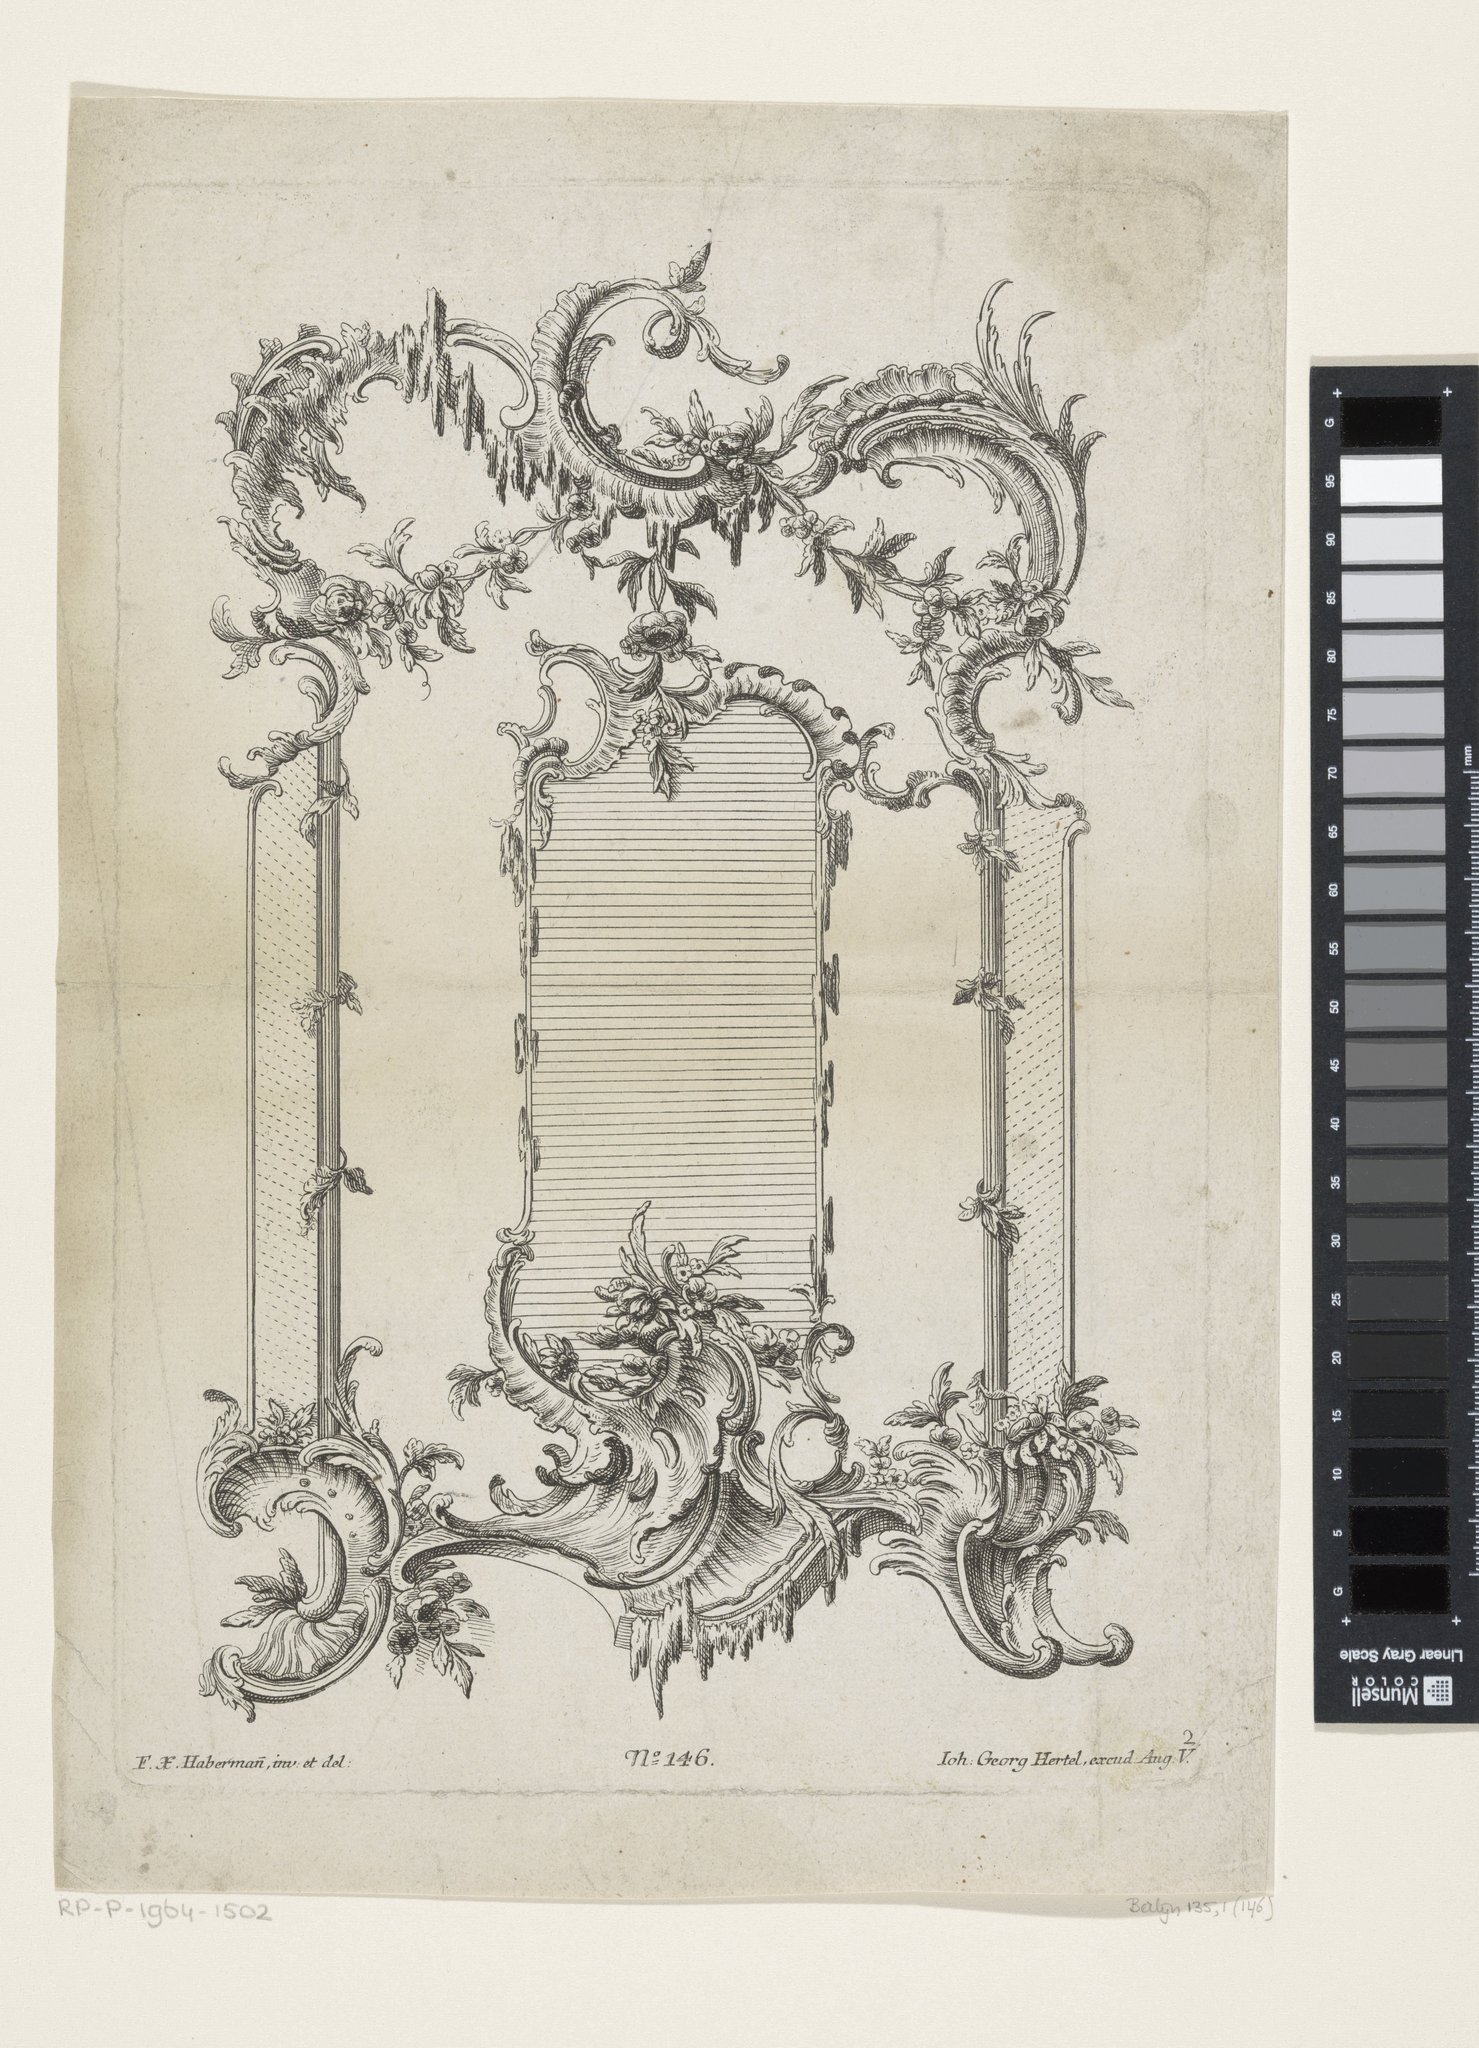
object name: print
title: Rocaille omlijsting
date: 1731-1775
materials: paper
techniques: etching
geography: augsburg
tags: rocaille ornament, ornaments ~ art (+ framing decorations)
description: Omlijsting met rocaille ornamenten, guirlandes en bloemmotieven. Uitgeversnummer 146.